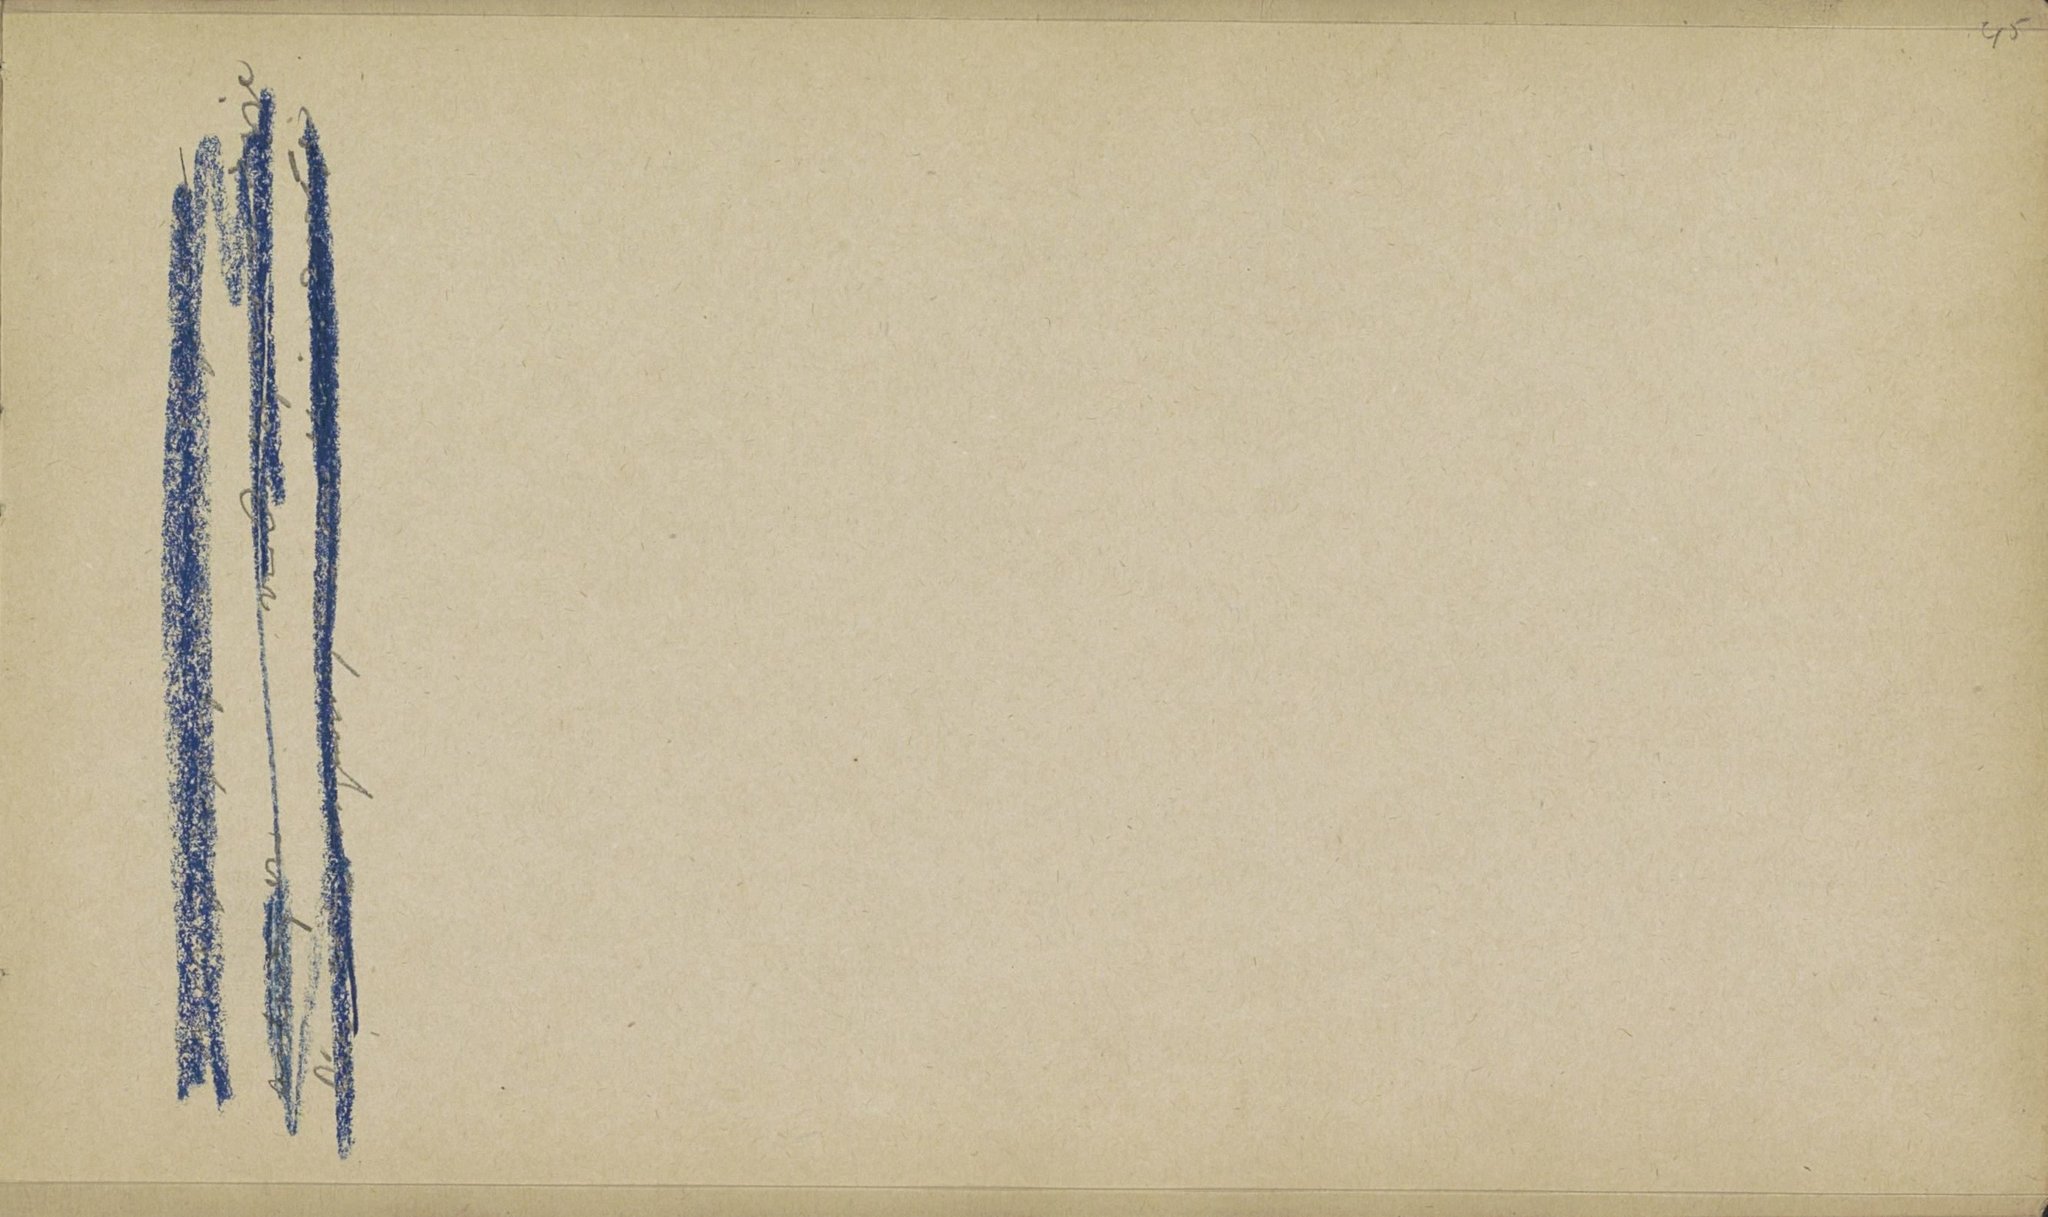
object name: sketchbook leaf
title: Doorgestreepte annotaties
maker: willem witsen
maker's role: draughtsman, painter, print maker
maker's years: 1860-1923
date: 1888-1897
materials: chalk, paper, pencil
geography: netherlands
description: Pagina 45 uit een schetsboek met 25 bladen.